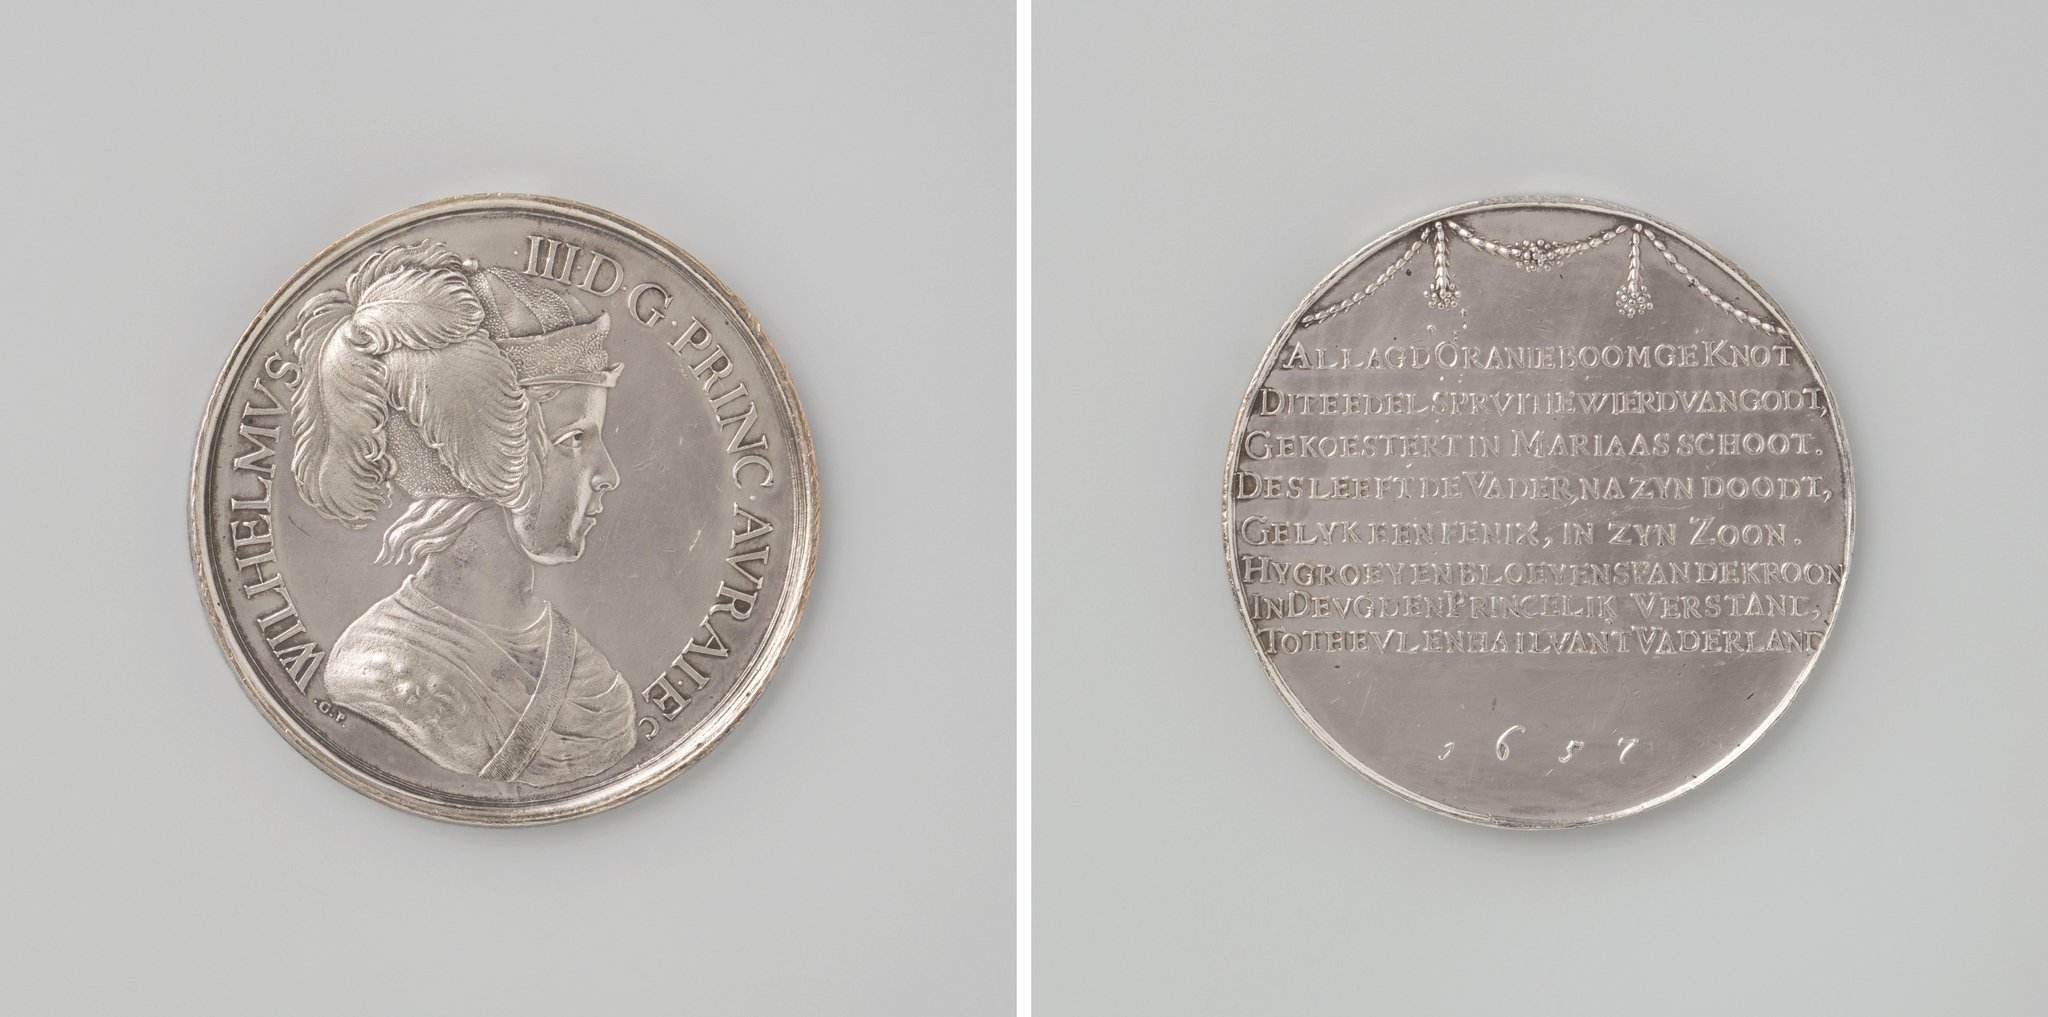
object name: history medal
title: Onenigheid in de Staten van Overijssel over de verkiezing van Willem III tot stadhouder van Overijssel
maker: juriaen pool (i)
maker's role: medailleur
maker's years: 1618-1669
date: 1657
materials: silver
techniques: striking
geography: amsterdam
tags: william iii (prince of orange and king of england, scotland, and ireland)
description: Zilveren penning. Voorzijde: borststuk jongeman met vederbaret binnen omschrift. Keerzijde: opschrift.